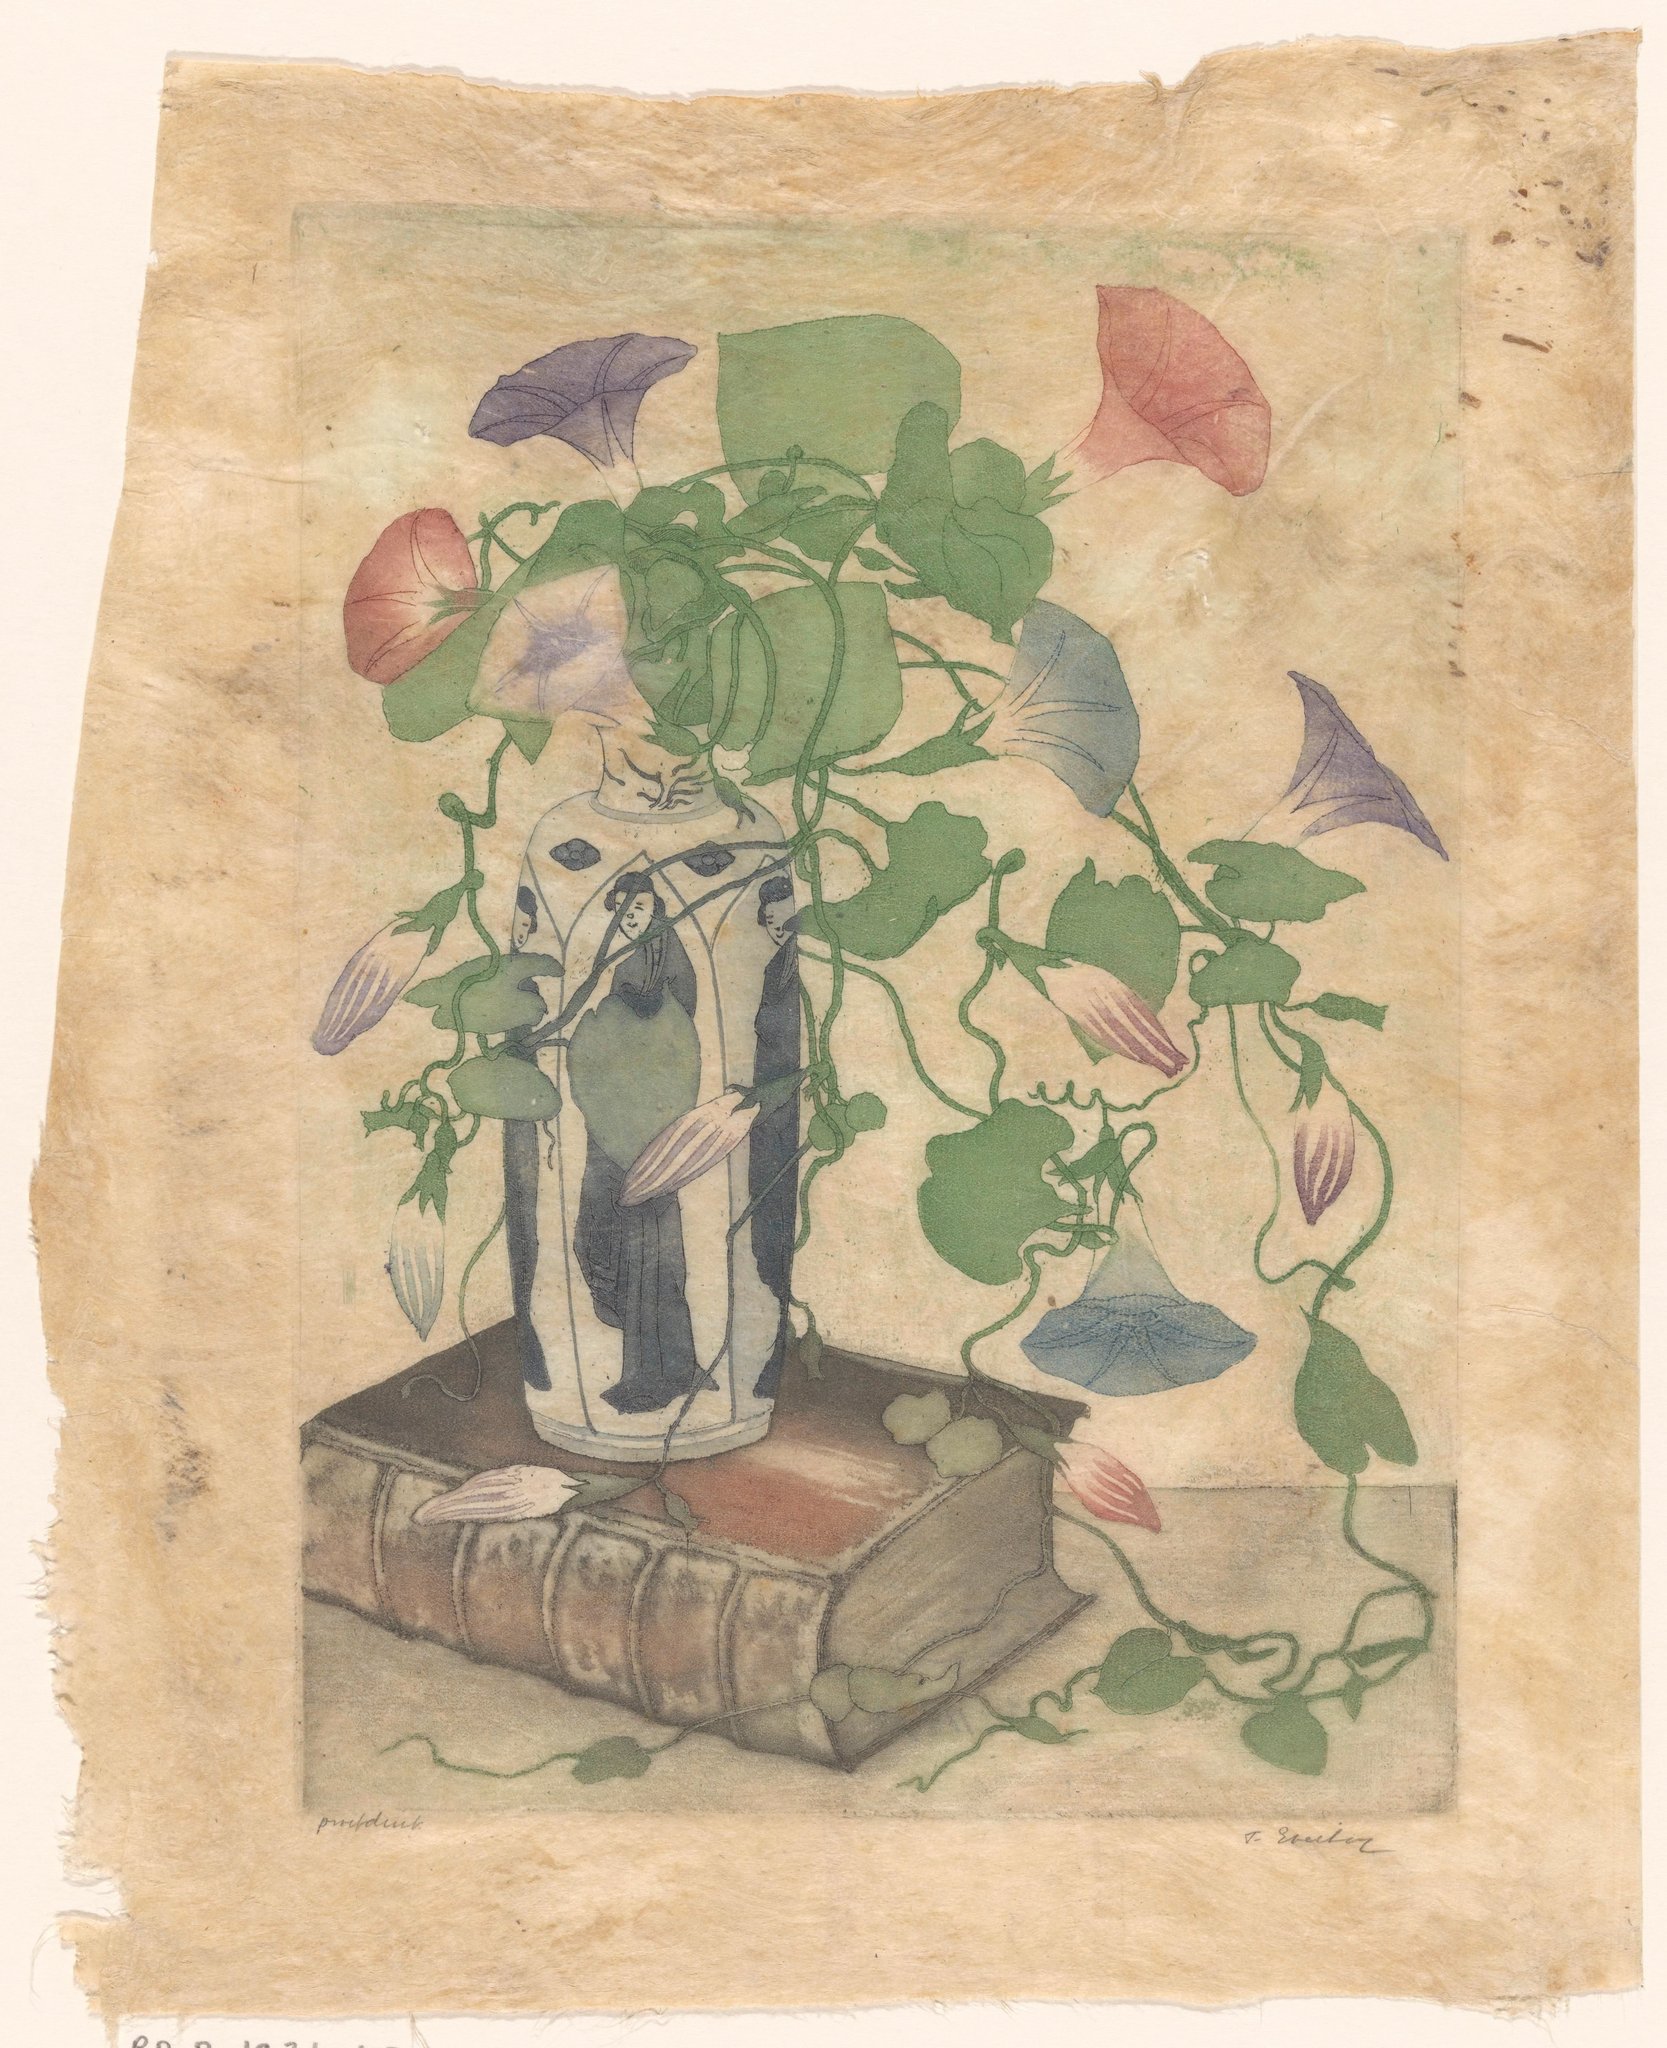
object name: print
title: Winde in een vaas van aardewerk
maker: frans everbag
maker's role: draughtsman, print maker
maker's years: 1877-1947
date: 1887-1931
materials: paper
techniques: aquatint, etching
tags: flowers, container of ceramics: jar, jug, pot, vase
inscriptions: collector's mark: Lugt 2228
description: Op de vaas zijn staande figuren afgebeeld. De vaas staat op een boek.